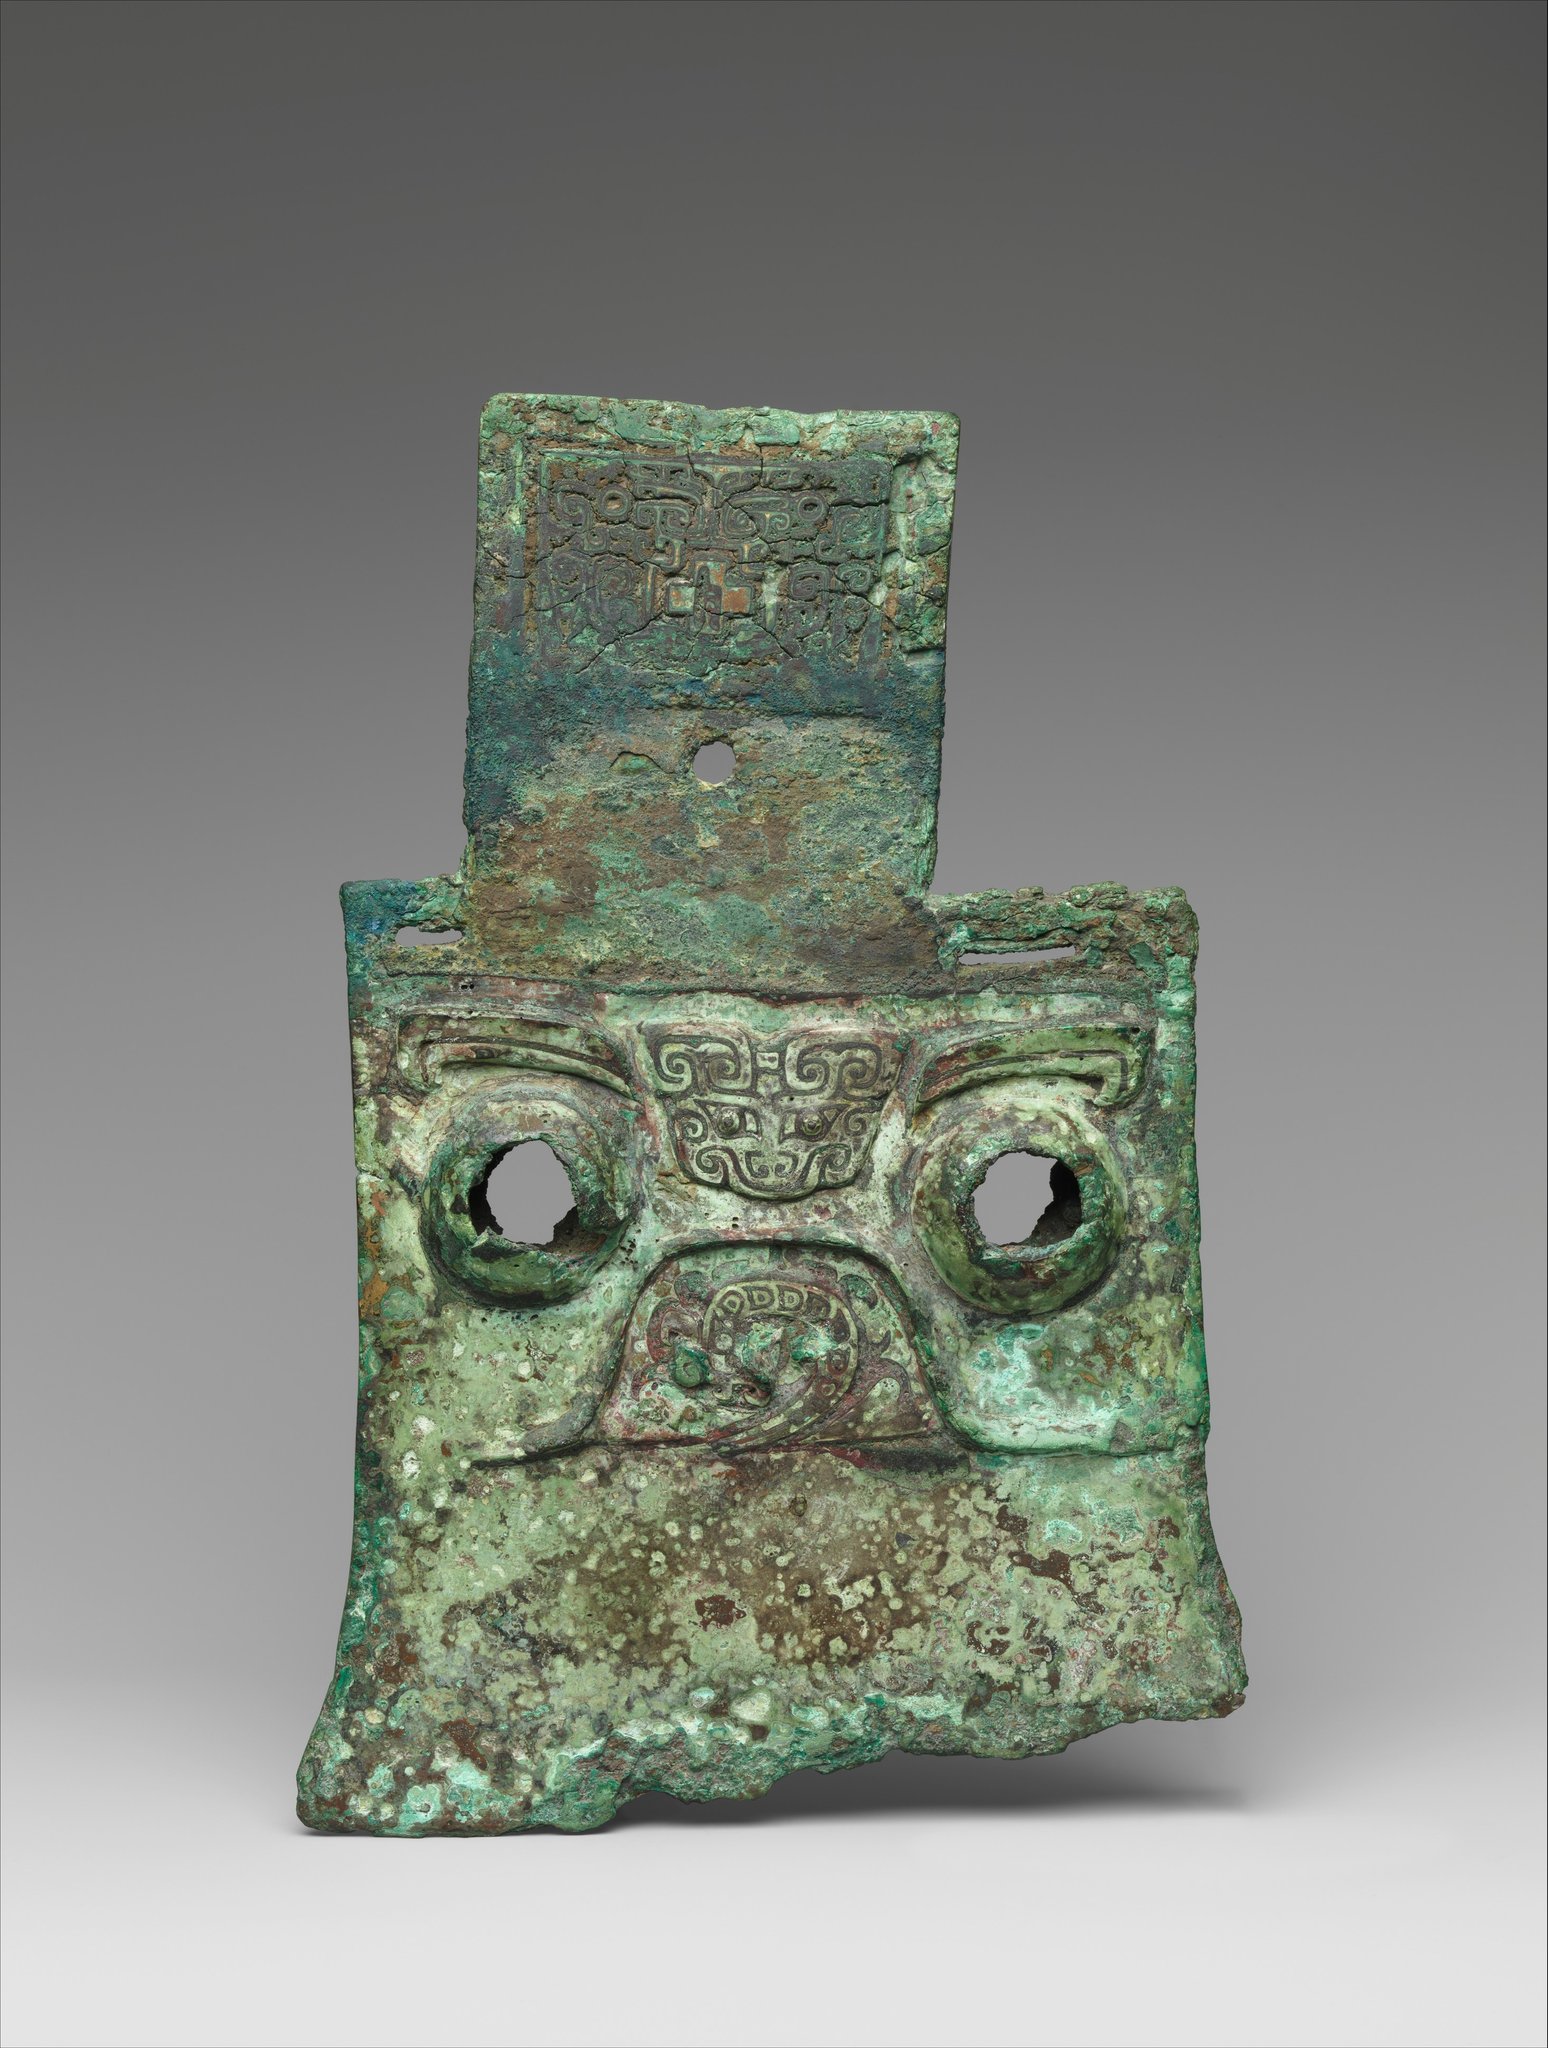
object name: axe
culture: chinese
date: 1300-1001 BCE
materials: bronze